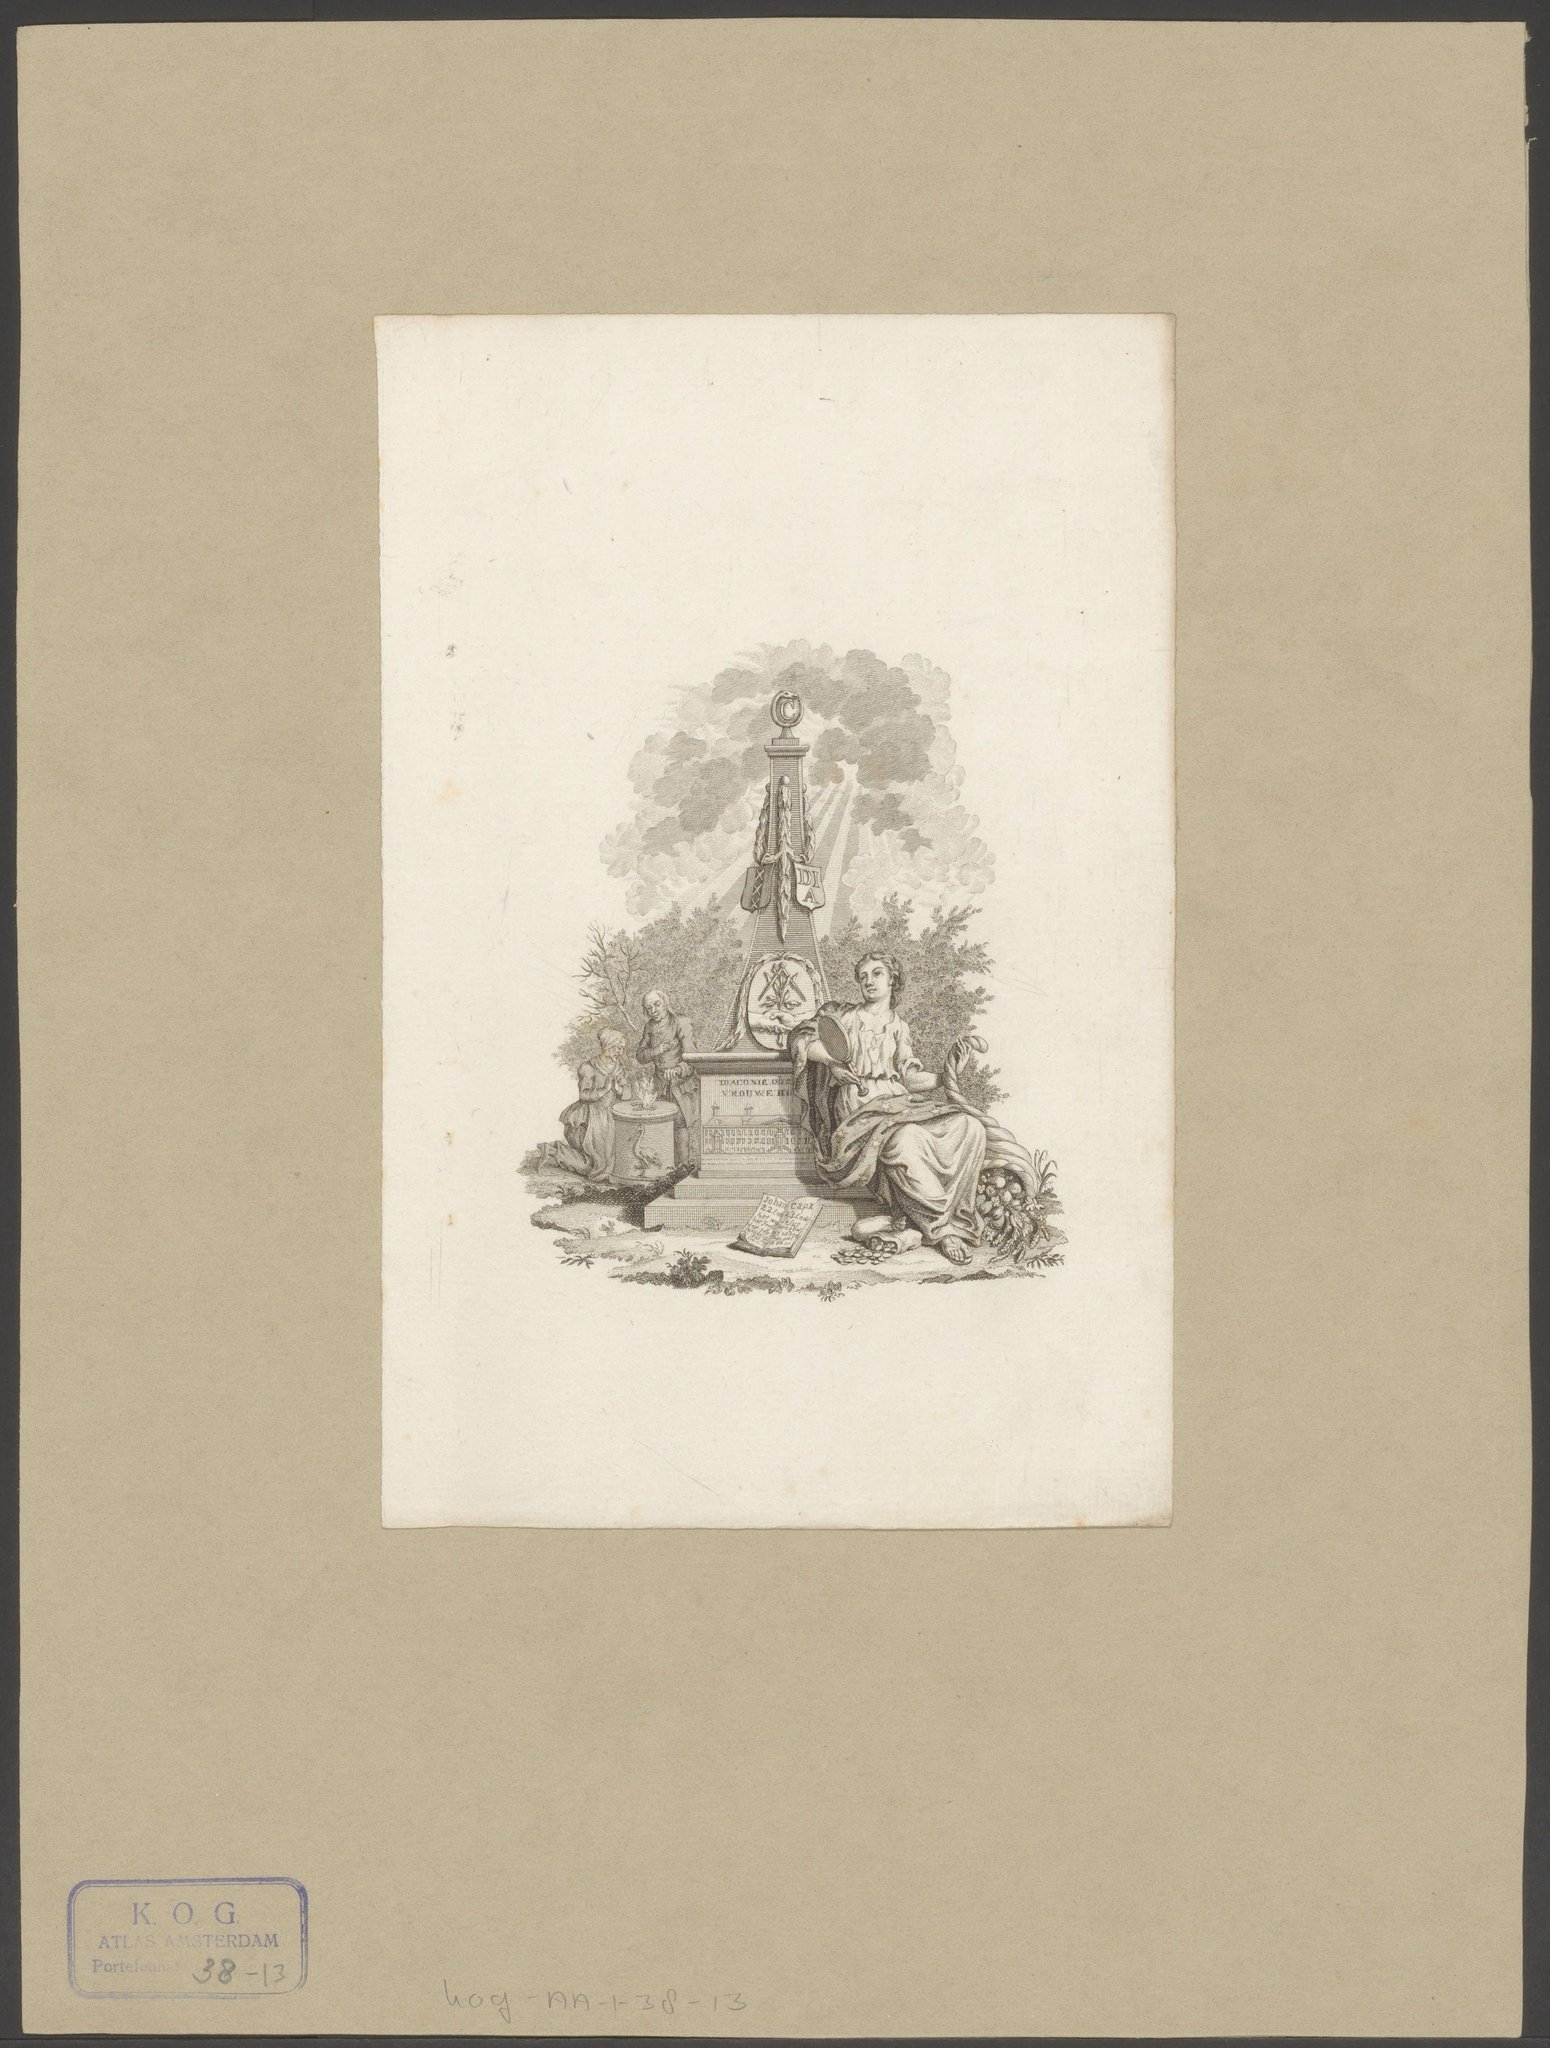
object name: print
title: Allegorisch monument voor het Diaconie Oude Vrouwen- en Mannenhuis te Amsterdam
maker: Anonymous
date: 1750-1800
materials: paper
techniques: etching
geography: northern netherlands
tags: 'cornucopia', horn of plenty, old man, old woman, monument, statue, old-people's home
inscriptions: collector's mark: Lugt 1641b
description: Onderwerpsrubriek binnen de Atlas Amsterdam: Armwezen en liefdadige instellingen: II. Kerkelijke inrichtingen: Diaconie Oude Mannen- en Vrouwenhuis der Ned. Herv. Gem.